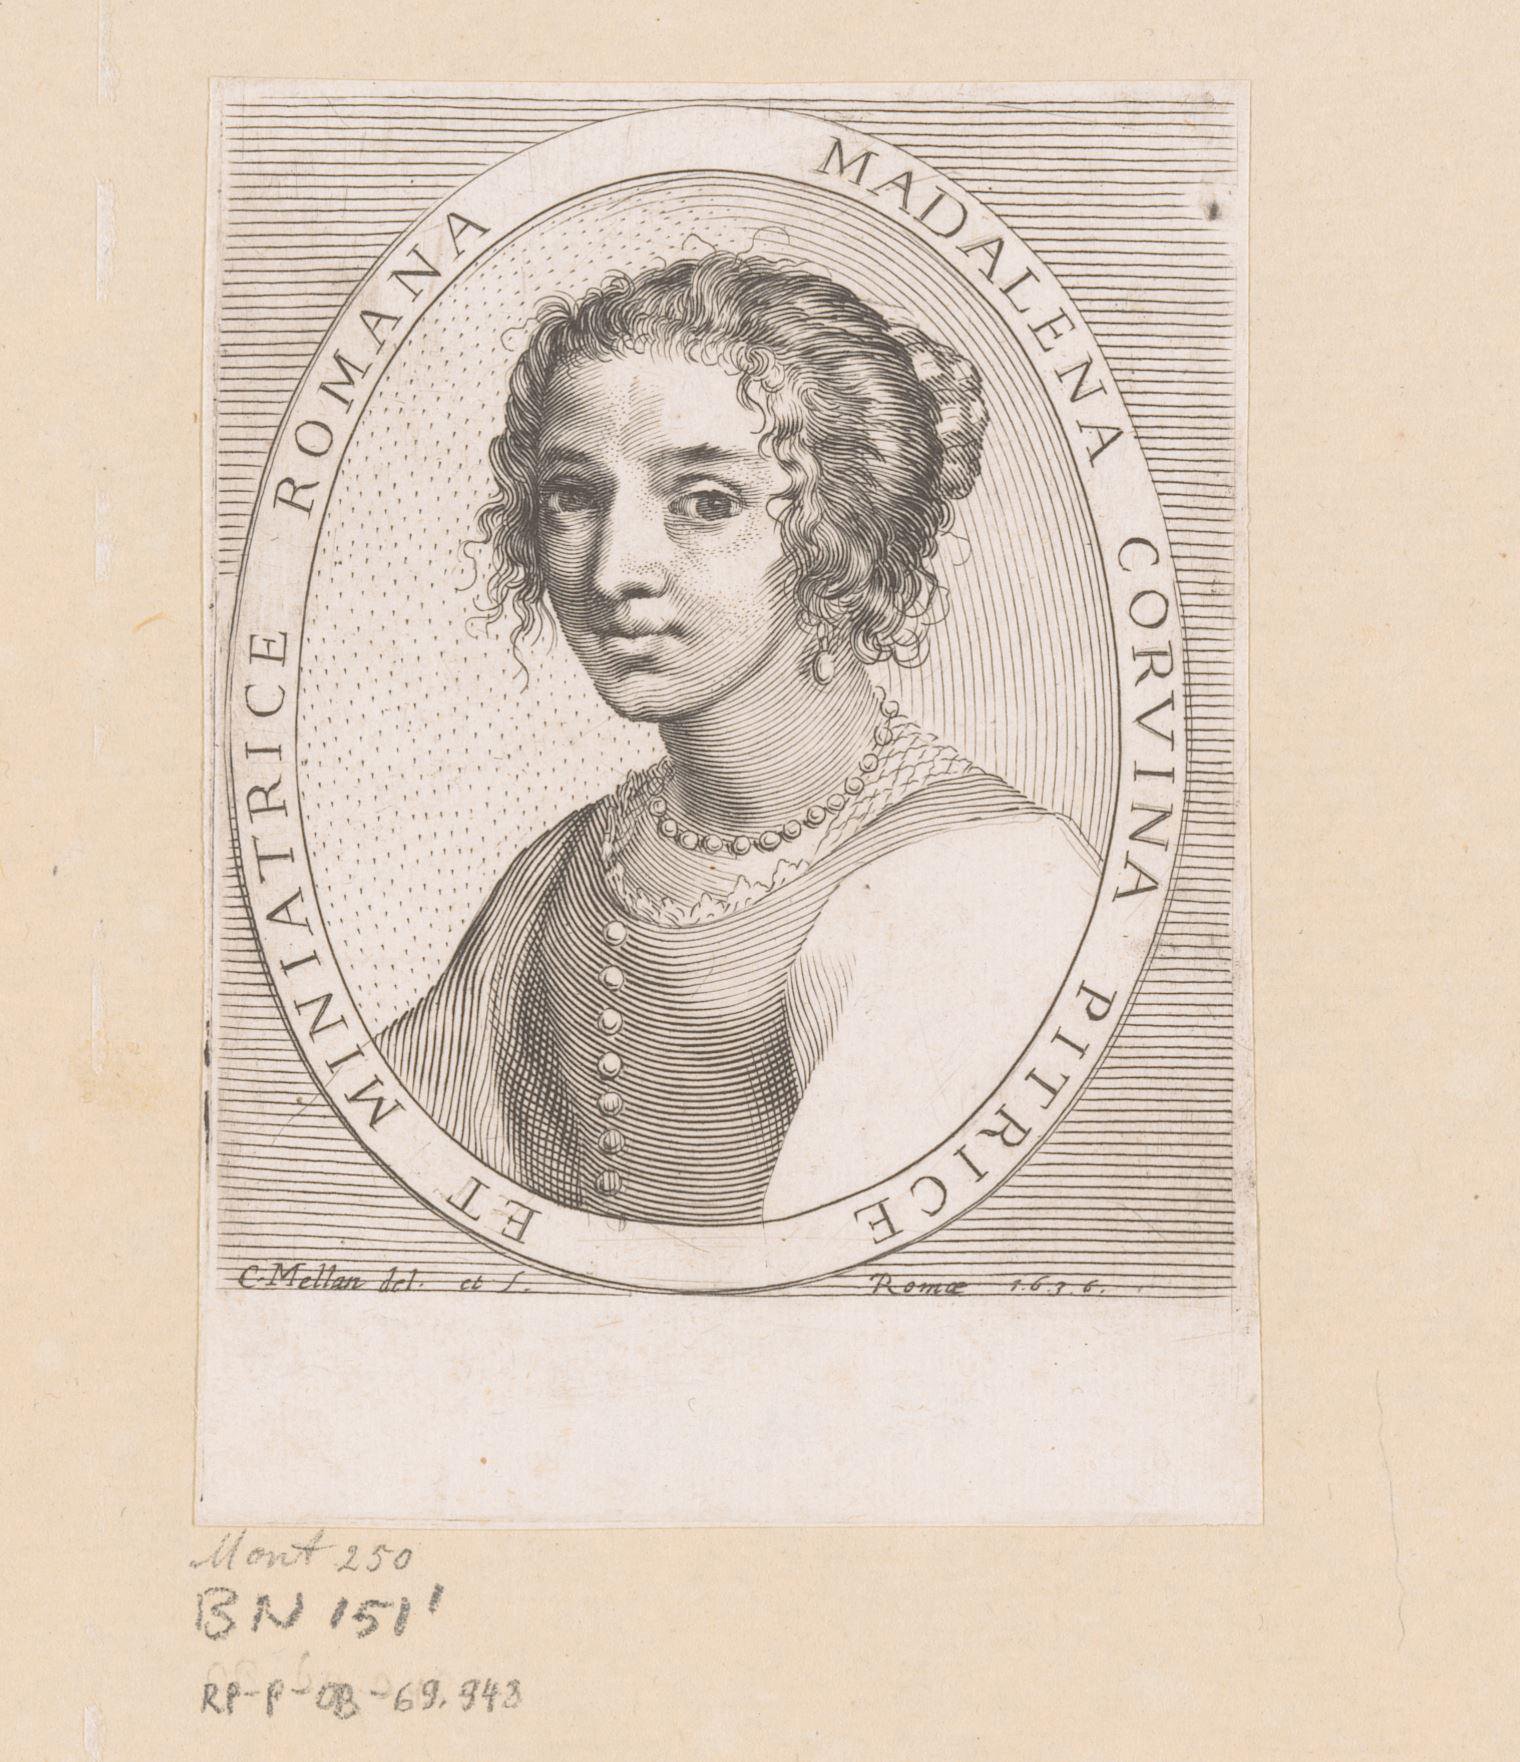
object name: print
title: Portret van Maddalena Corvina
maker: claude mellan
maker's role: draughtsman, print maker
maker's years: 1598-1688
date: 1636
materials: paper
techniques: engraving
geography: rome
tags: painter, print maker, maddalena corvina, historical persons - bb - woman, portrait, self-portrait of artist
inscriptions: collector's mark: Lugt 240